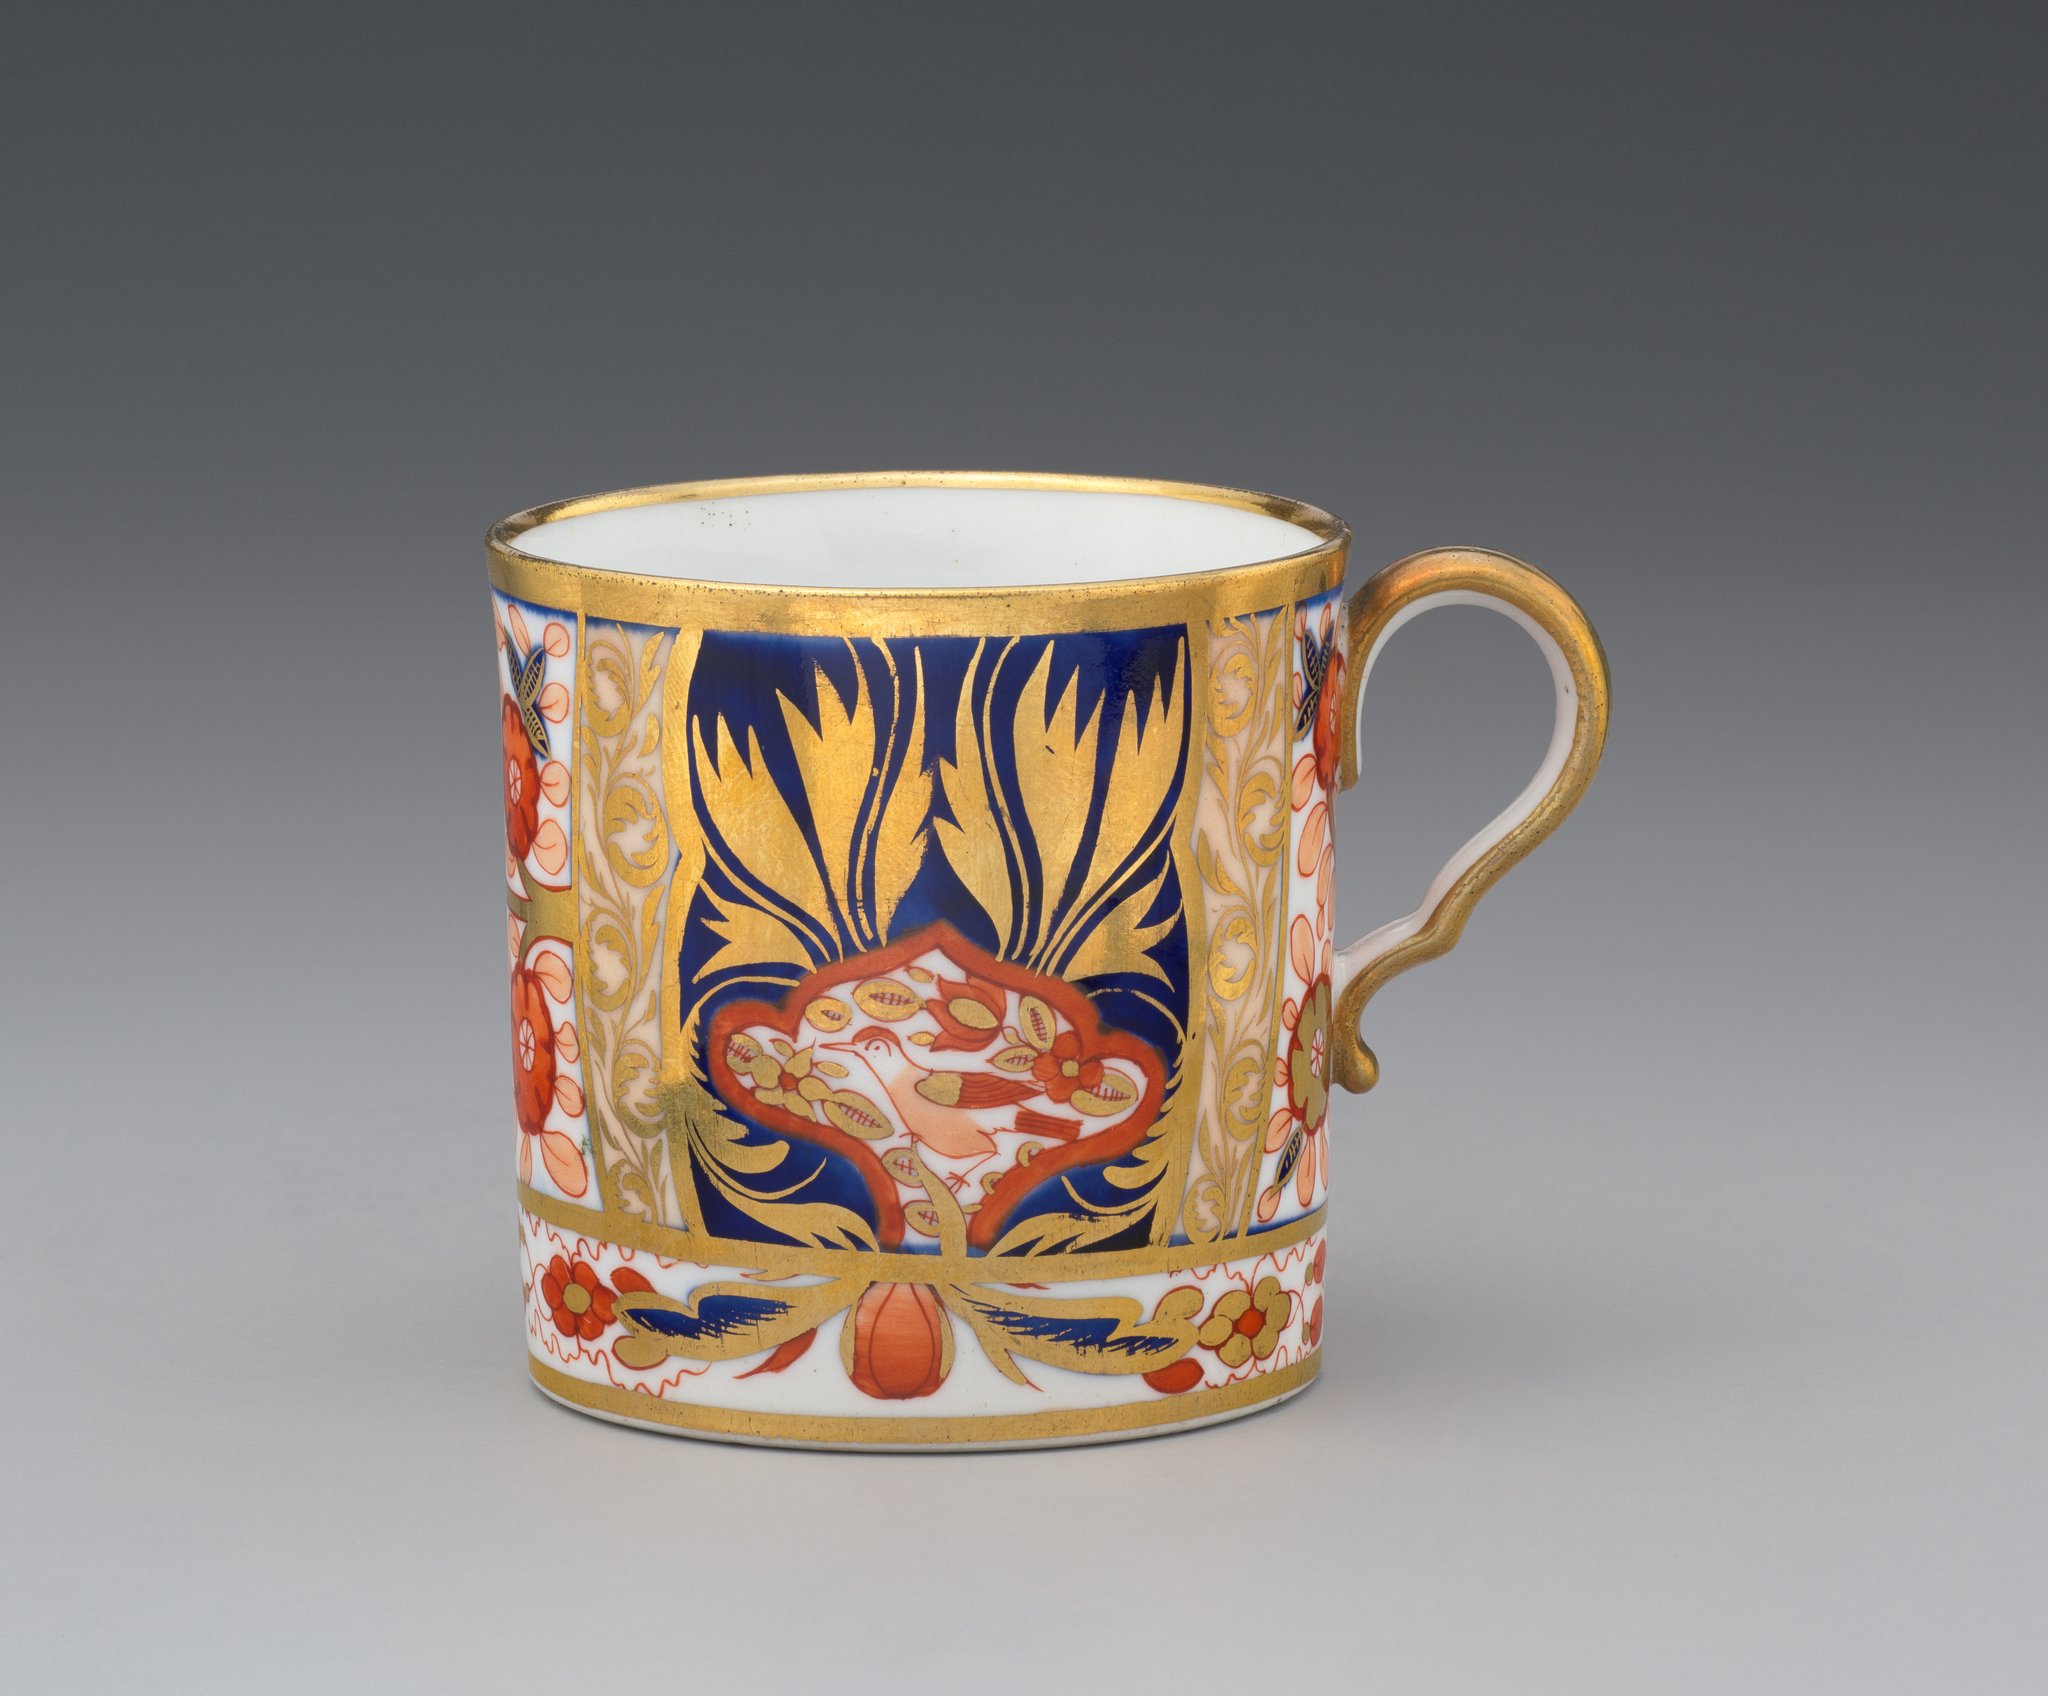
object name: cup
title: Cup (part of a service)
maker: j. spode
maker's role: factory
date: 1800-1830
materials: soft paste porcelain